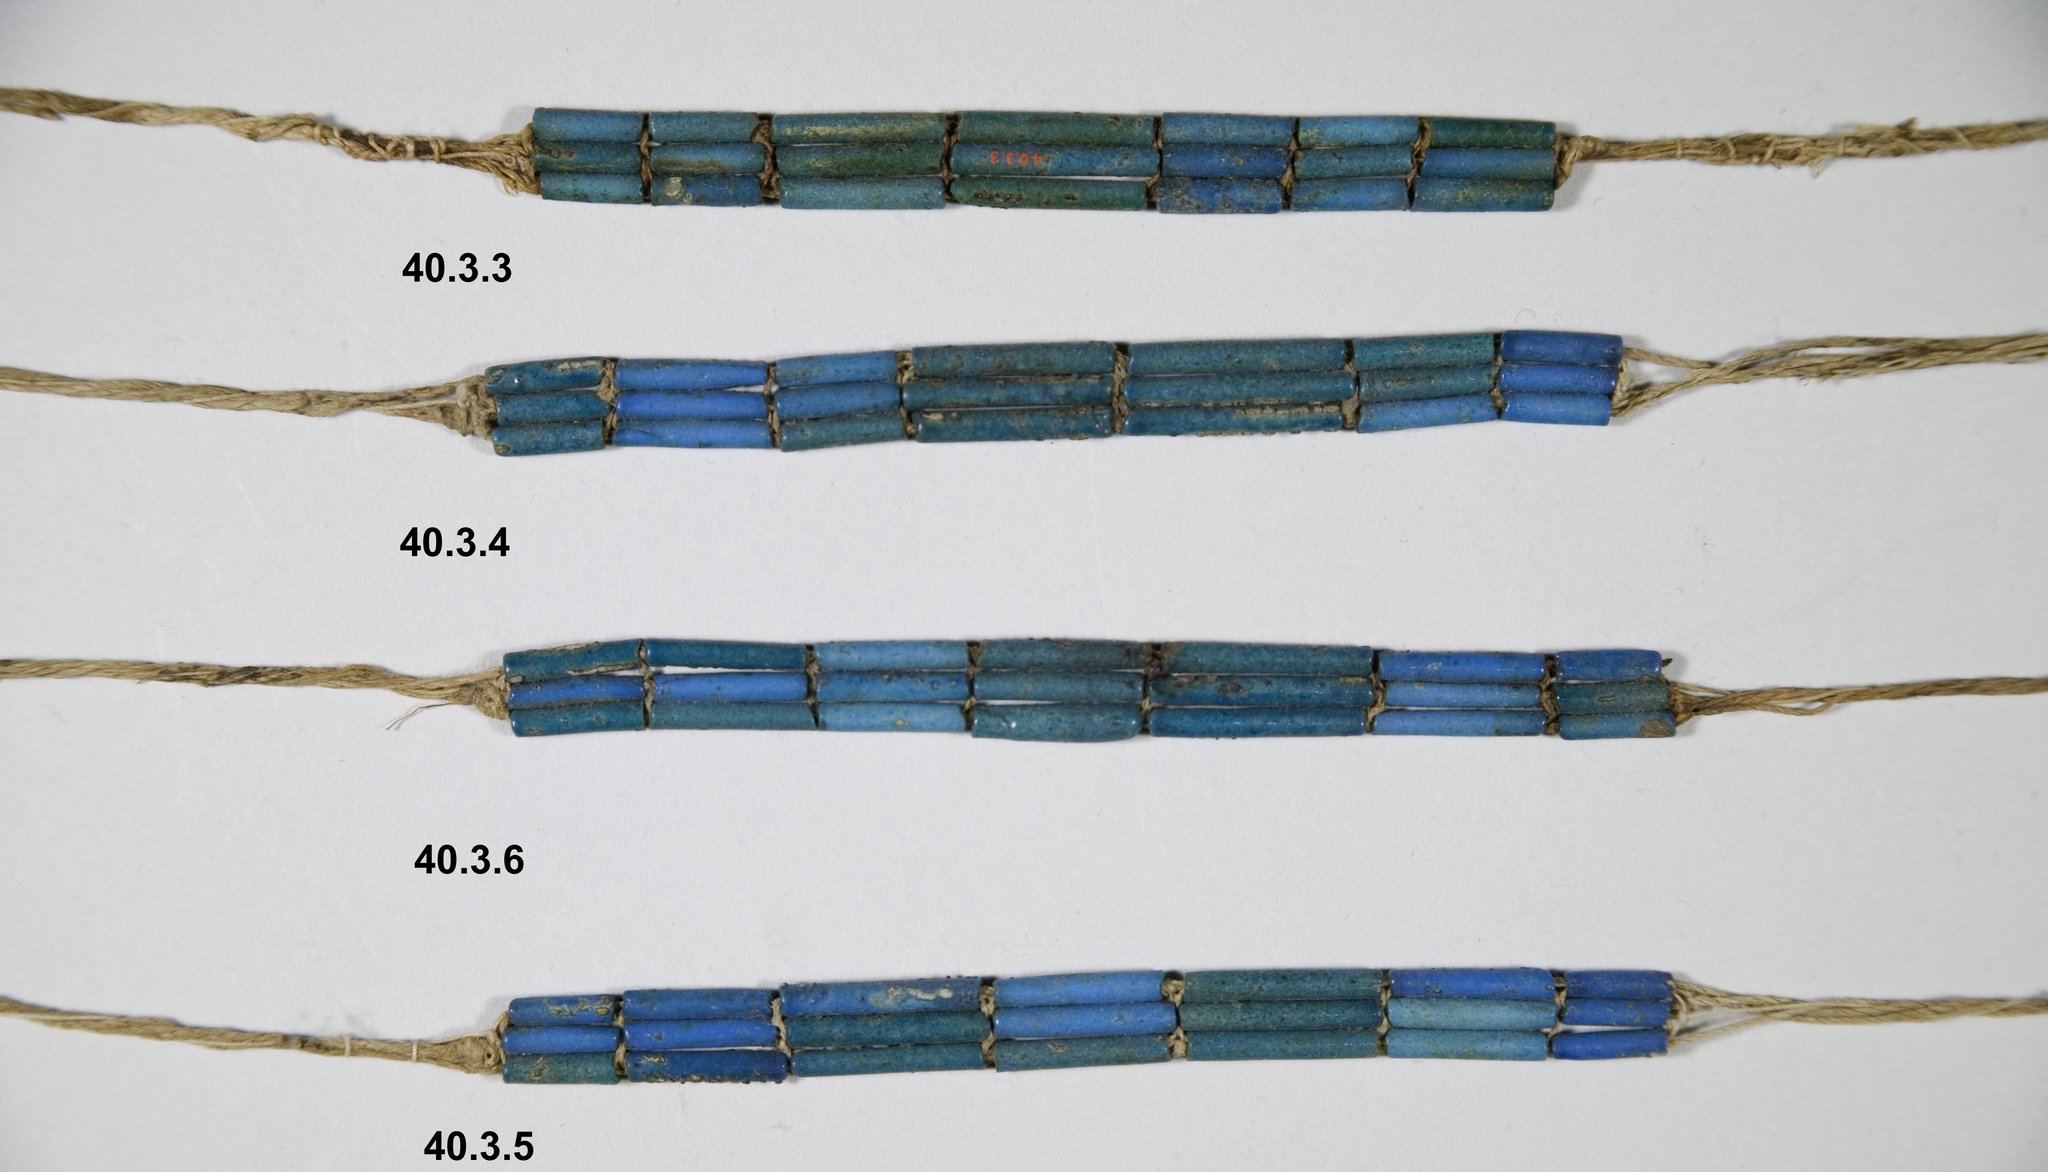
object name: bracelet, wah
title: Bracelet of Wah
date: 1981-1975 BCE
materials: cord, faience, linen, thread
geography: egypt